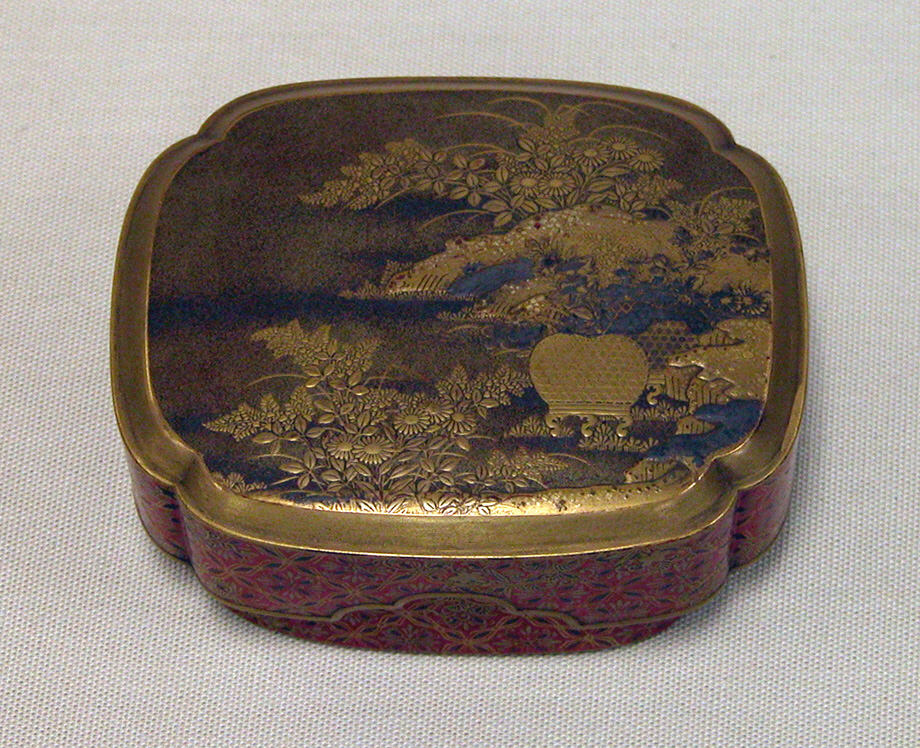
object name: incense box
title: Incense Box with Autumn Grasses and Insect Cage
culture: japanese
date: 1834-1866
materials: gold, gold foil, silver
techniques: cutting, hiramakie, maki-e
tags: flowers